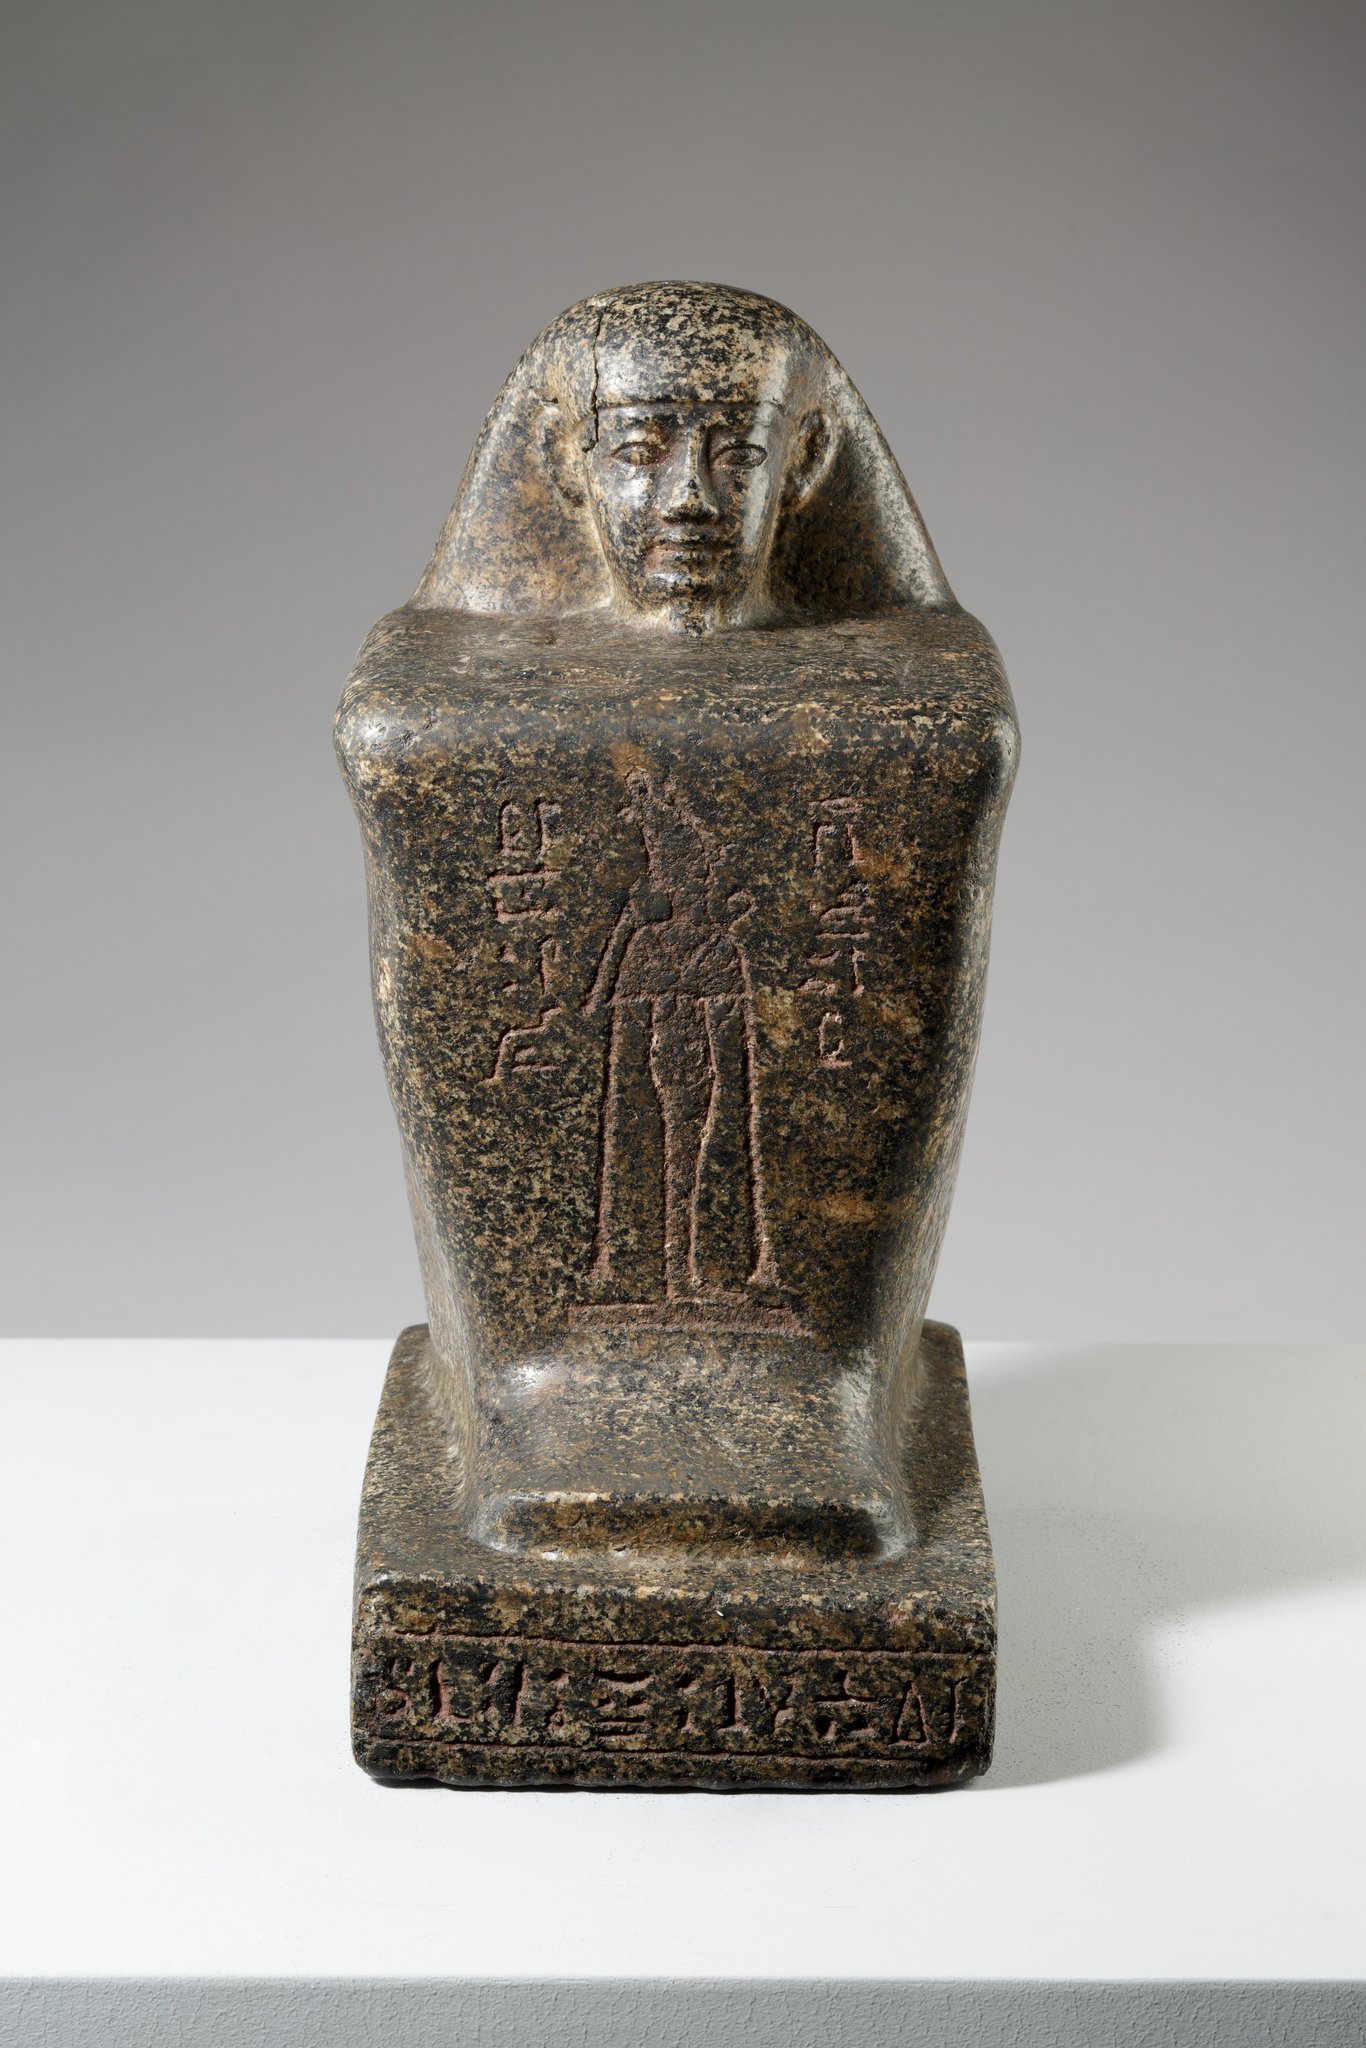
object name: block statue, neskhemnyu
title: Block Statue of Neskhemenyu, son of Kapefha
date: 400-301 BCE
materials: pigment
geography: egypt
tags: men,hieroglyphs